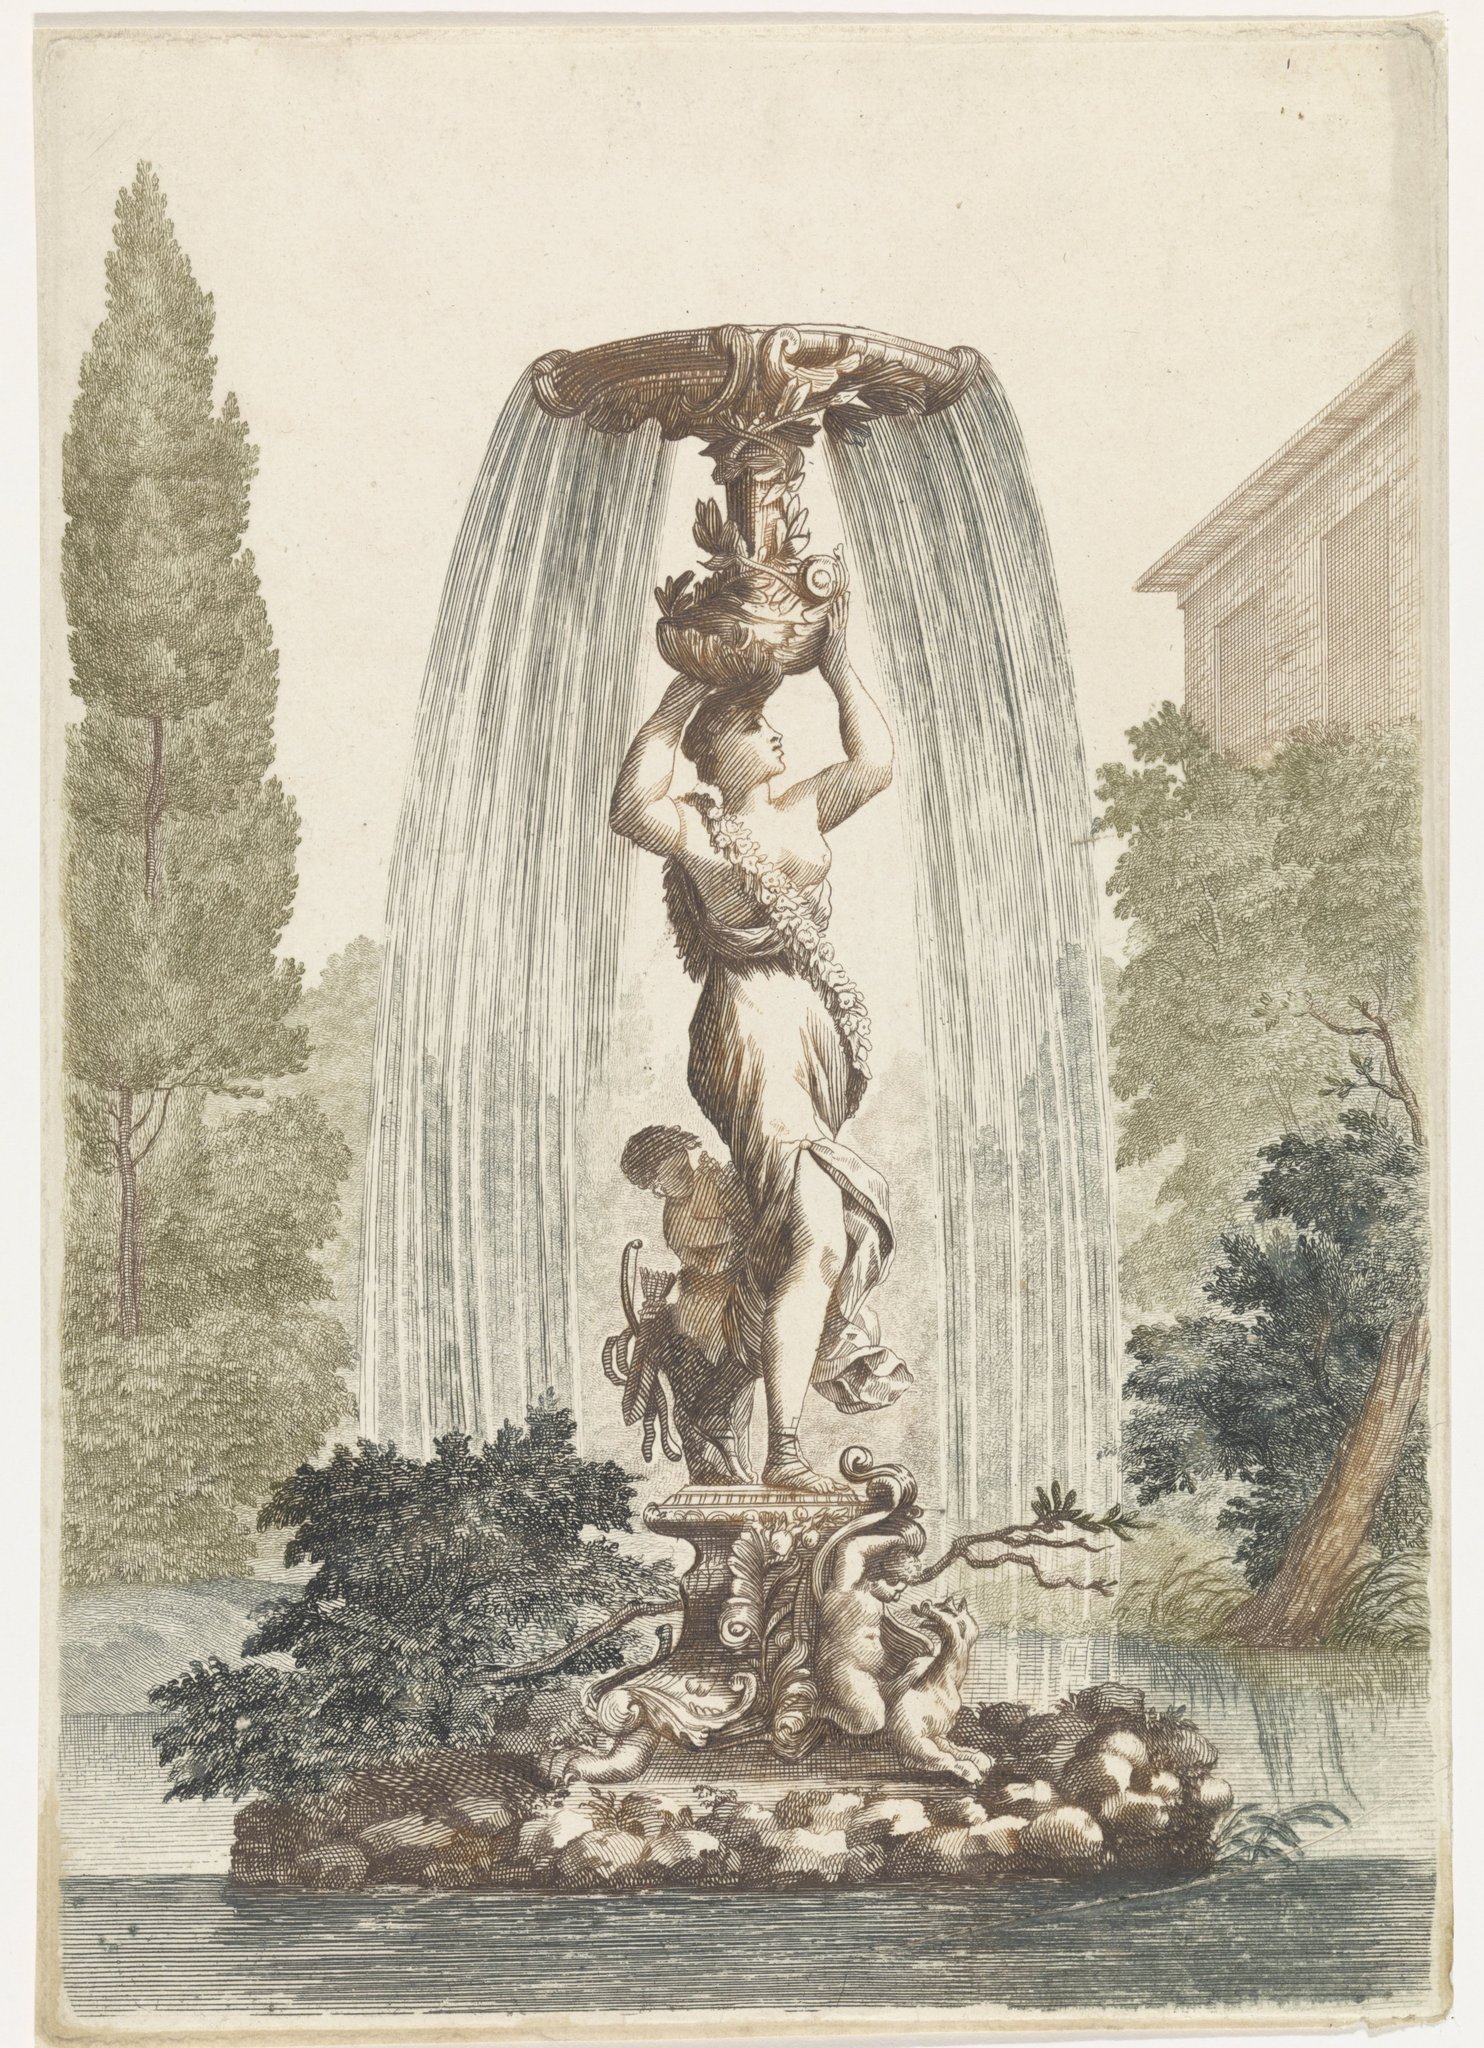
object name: print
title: Fontein met Venus en Amor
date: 1688-1698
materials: paper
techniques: engraving, etching, lithography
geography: netherlands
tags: garden fountain, venus and cupid (cupid not being mere attribute)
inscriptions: collector's mark: Lugt 2228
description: Fontein met Venus en Amor staande op een ornamentele sokkel. Venus draagt het waterbekken.